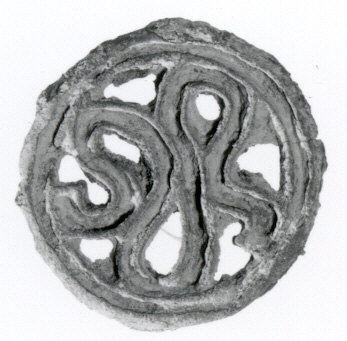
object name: stamp seal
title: Compartmented stamp seal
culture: bactria-margiana archaeological complex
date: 2333-1668 BCE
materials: copper alloy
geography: bactria-margiana